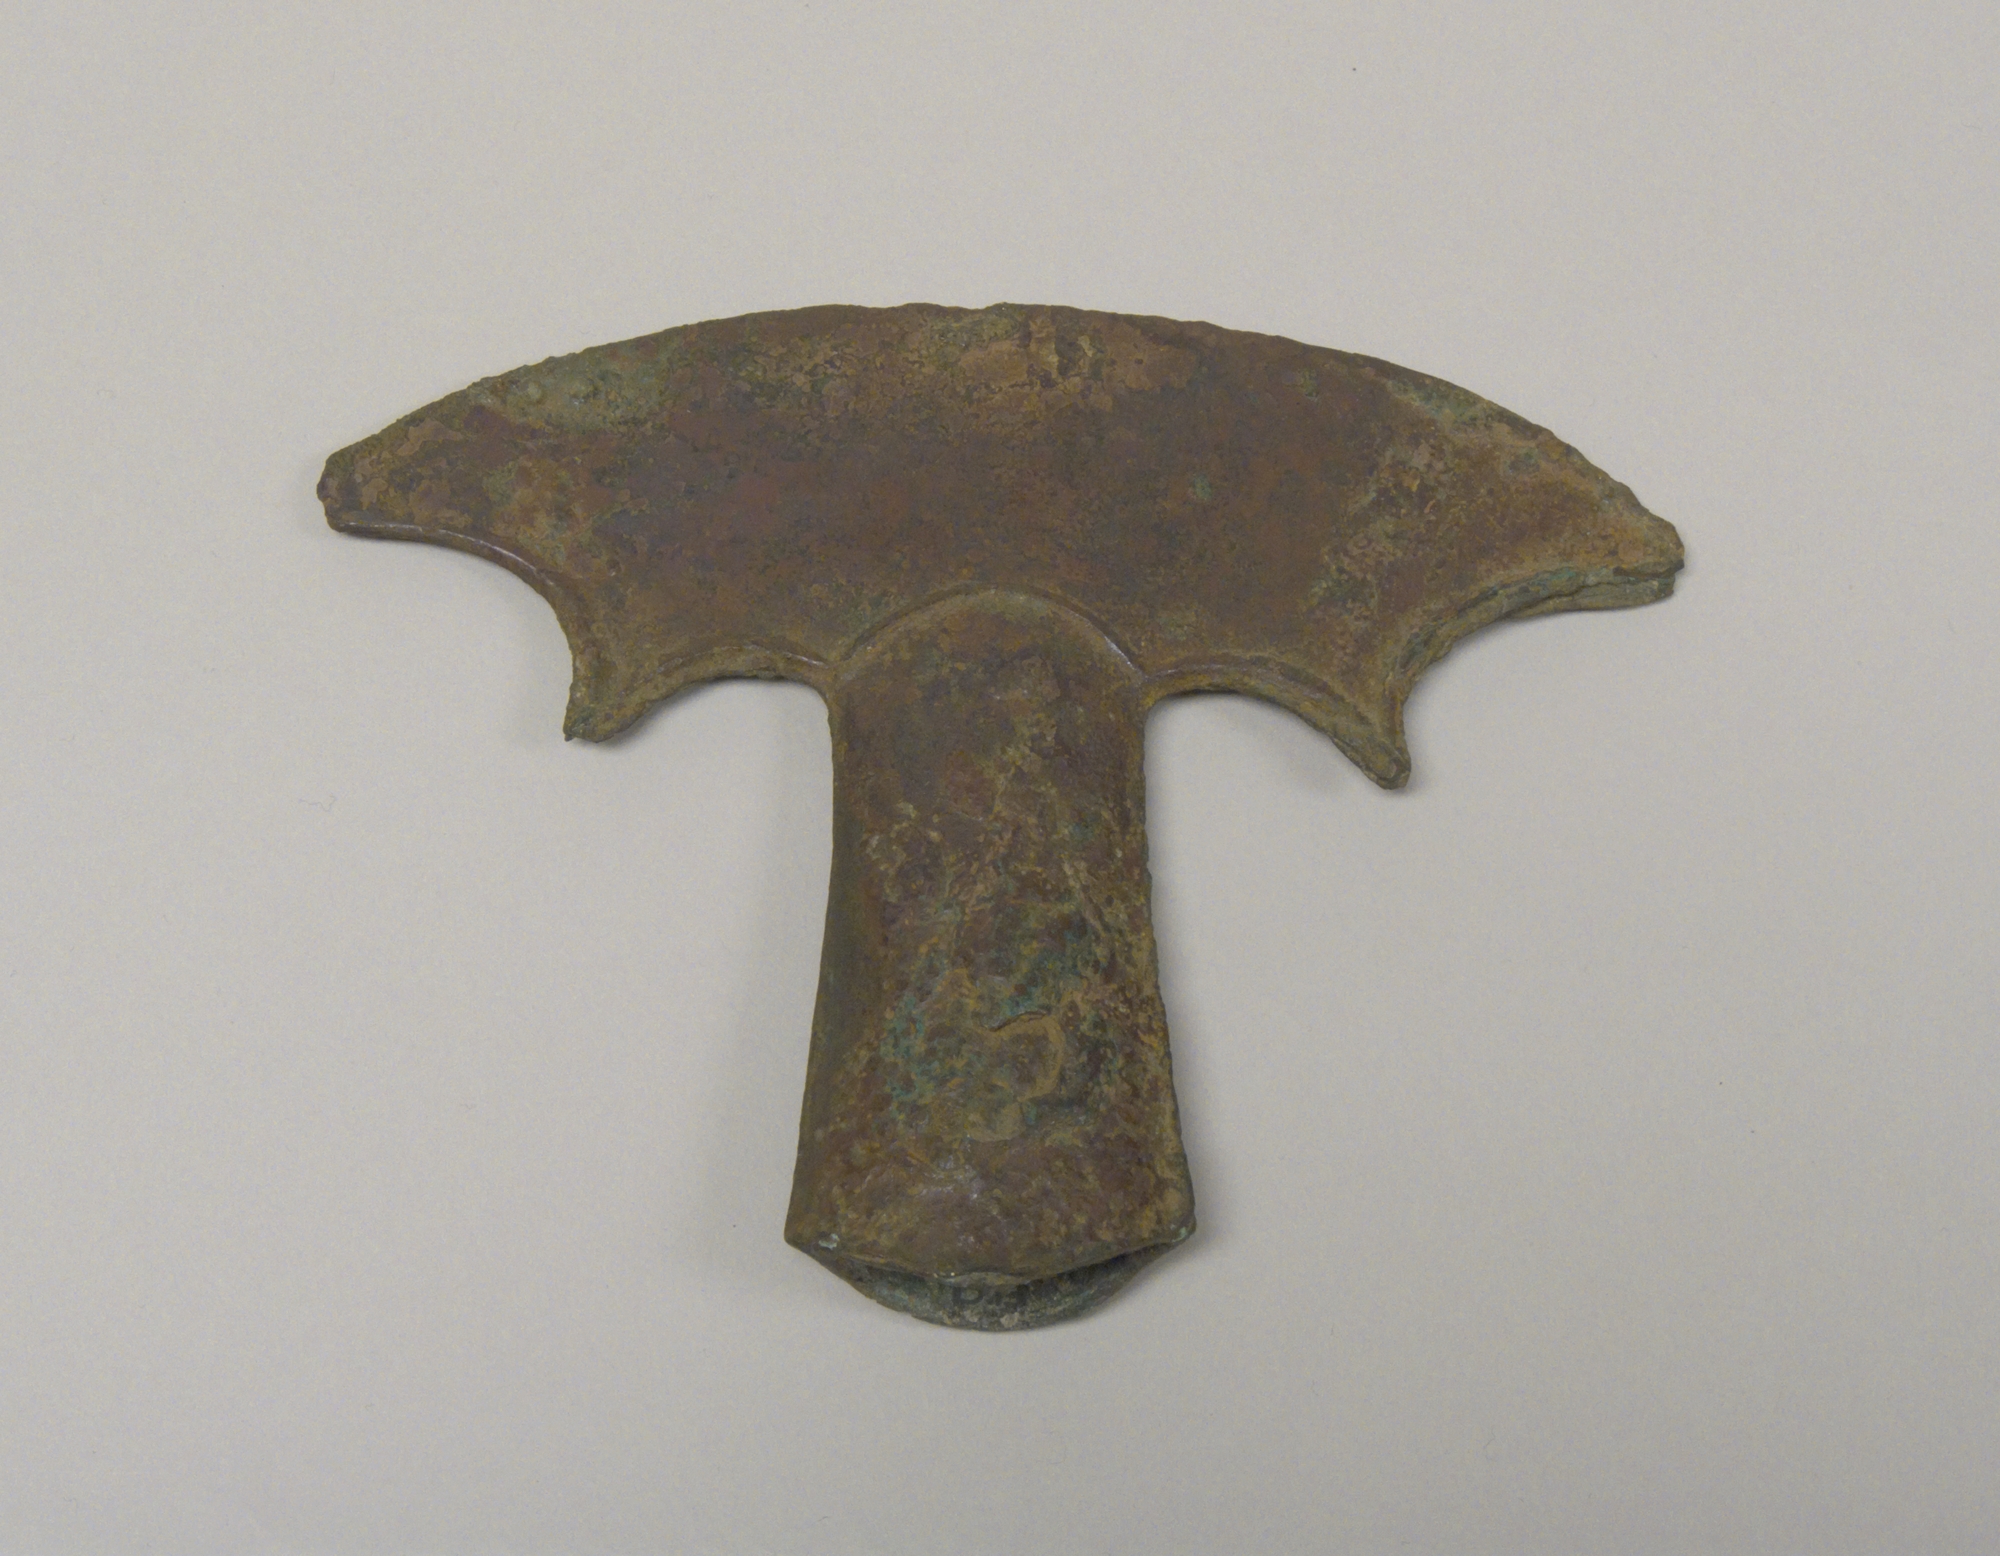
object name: socketed ax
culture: thai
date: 500 BCE-300 CE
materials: bronze